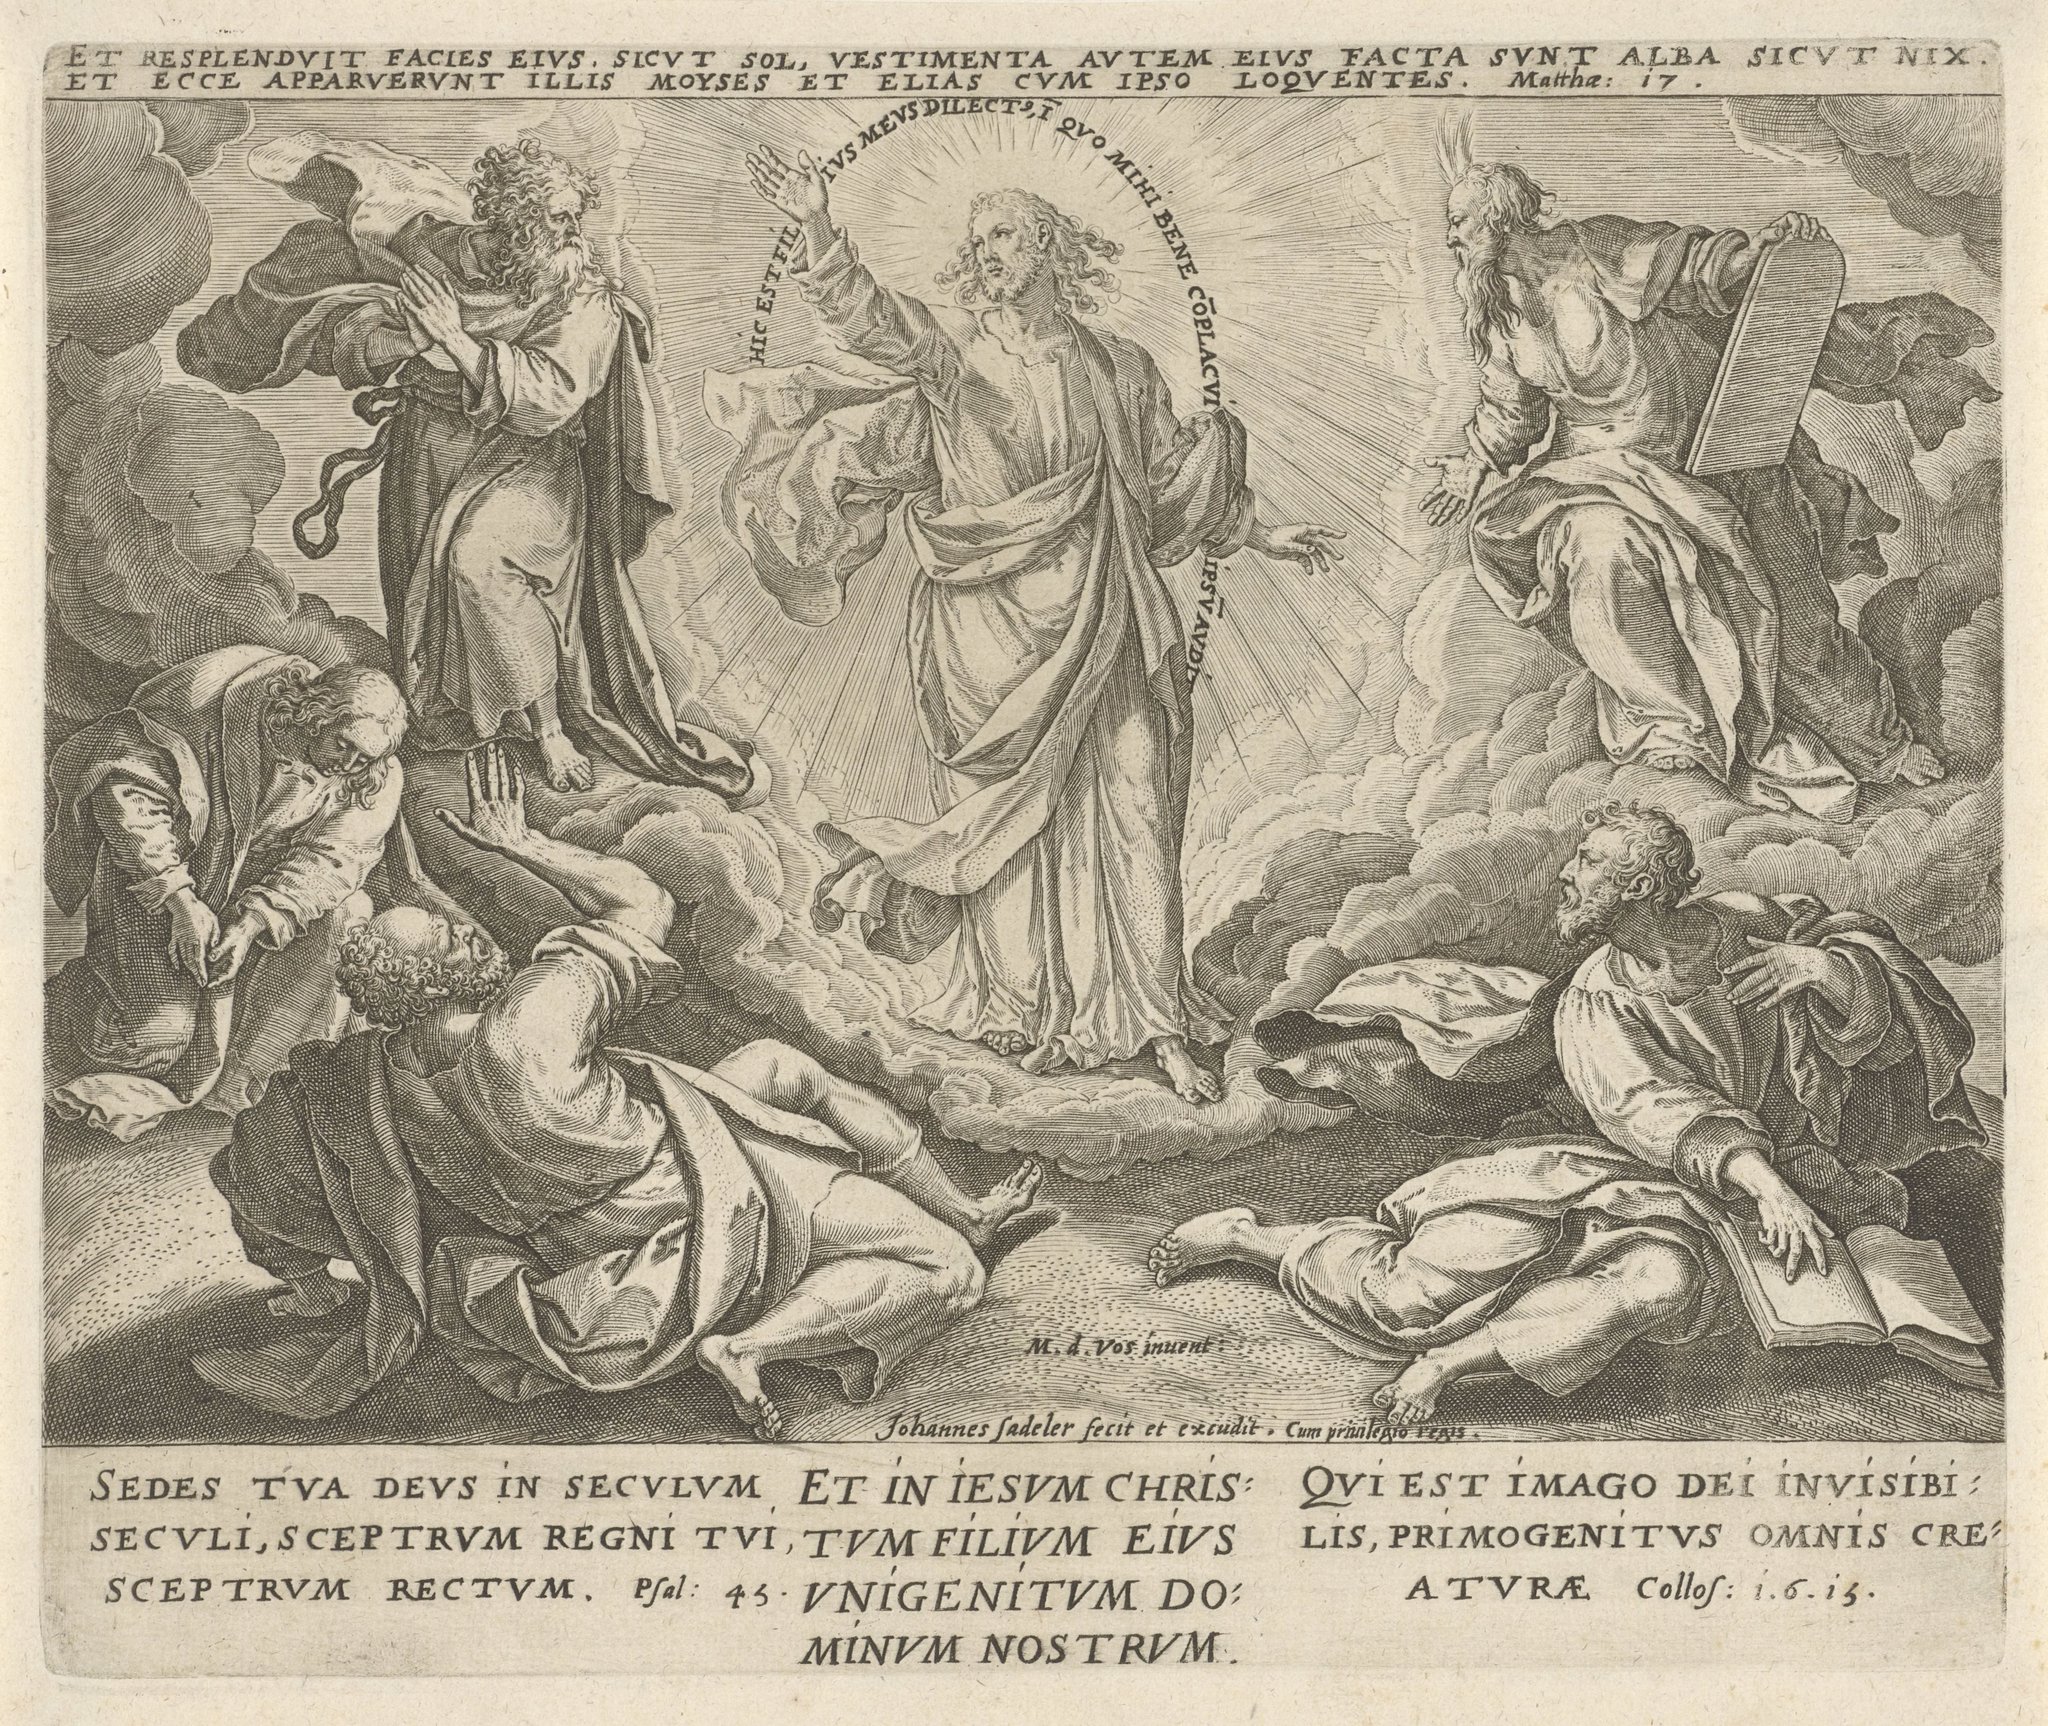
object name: print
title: Et in Jesvm Christvm Filivm Eivs vnigenitvm dominvm nostrvm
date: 1579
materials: paper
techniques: engraving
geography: cologne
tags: 'et in jesum christum filium eius' ~ articles of faith, the transfiguration: moses and elijah appear on either side of christ on mount tabor (matthew 17:1-13; mark 9:2-13; luke 9:28-36)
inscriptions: collector's mark: Lugt 240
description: Het tweede geloofsartikel: het geloof in Christus als zoon van God. Christus toont zijn goddelijk wezen aan zijn leerlingen Petrus, Jakobus de Meerdere en Johannes. Hij is omgeven door hemelse stralen. Mozes (rechts) en de profeet Elia (links) verschijnen naast hem. De prent heeft een Latijns opschrift met een Bijbelcitaat dat refereert aan het afgebeelde Bijbelverhaal en een Latijns onderschrift over de apostolische geloofsbelijdenis. De tweede prent in een twaalfdelige serie over het credo.